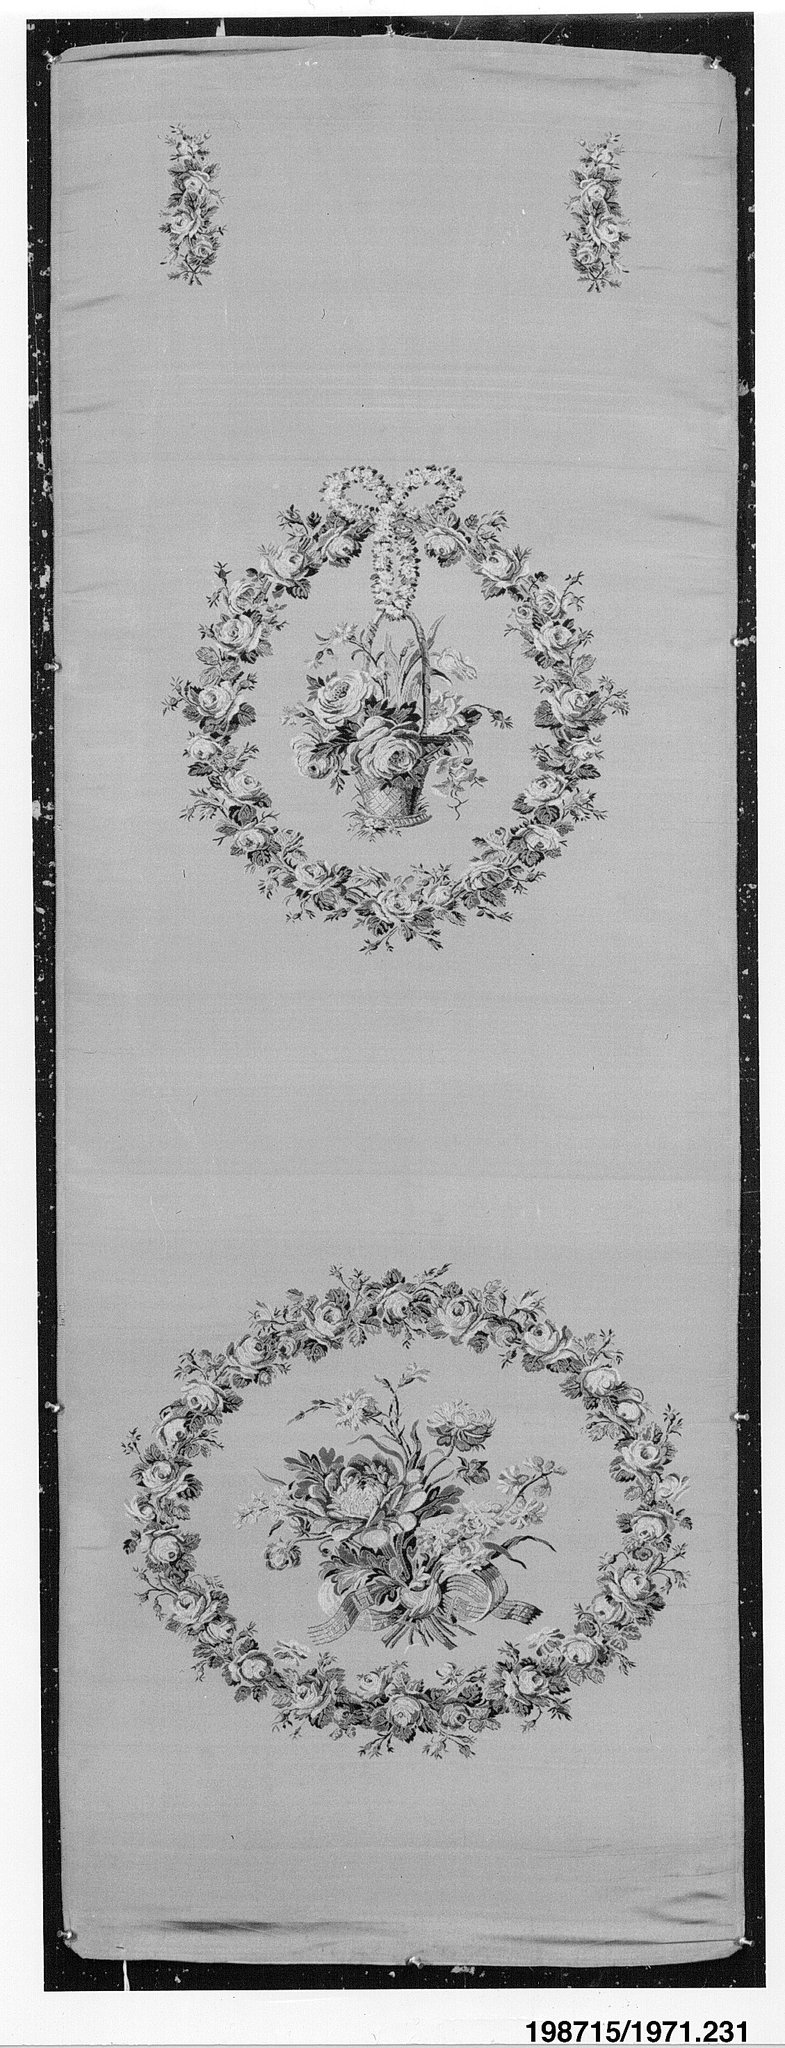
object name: length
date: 1880-1889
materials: silk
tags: flowers